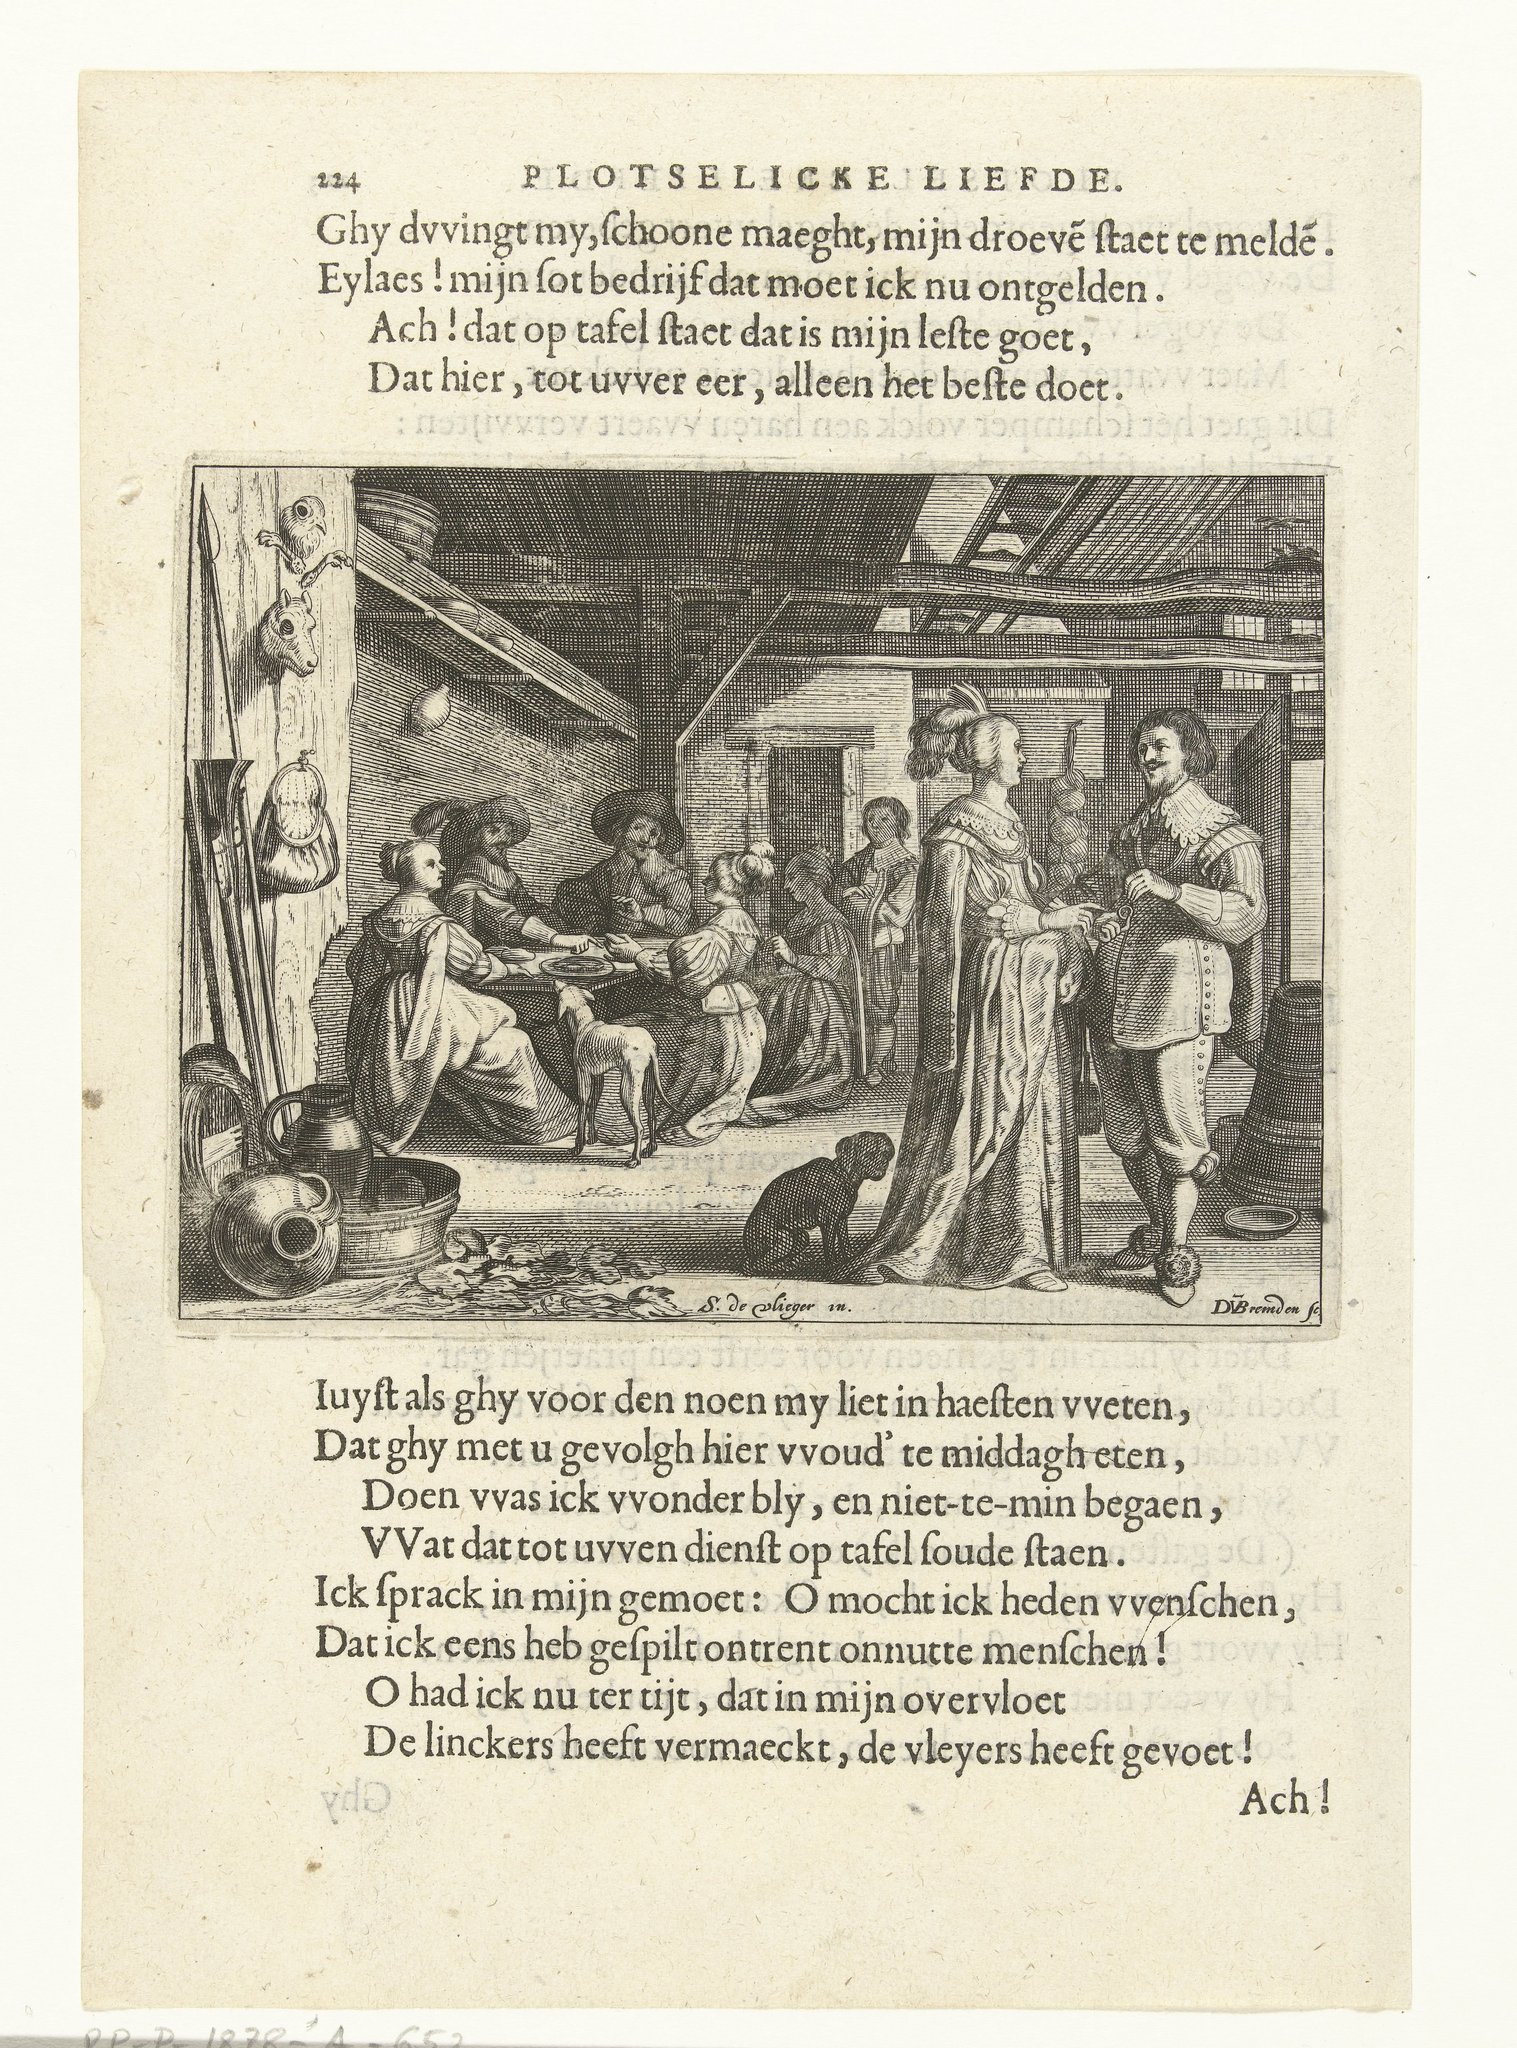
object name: print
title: Actaeon en Jolinde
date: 1537-1635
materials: paper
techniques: engraving, letterpress printing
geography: amsterdam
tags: evening meal, dinner, supper, proposal, declaration of love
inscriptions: collector's mark: Lugt 2228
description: Jolinde komt met haar gevolg plotseling bij Actaeon eten. Hij heeft niet echt iets in huis en maakt uit verlegenheid zijn valk klaar. Het eten smaakt vreemd en uiteindelijk biecht Actaeon Jolinde wat er werkelijk op tafel staat. Uit medelijden trouwt Jolinde met hem. Bladzijde uit een boek met tekst op recto en verso.